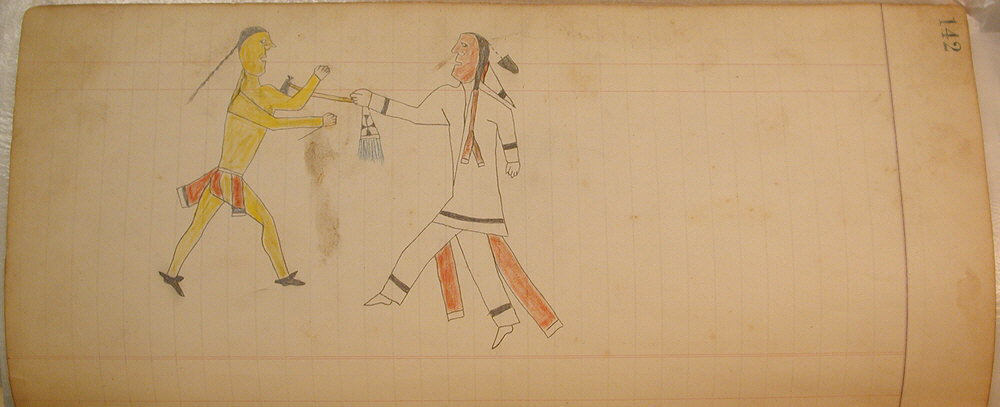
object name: drawing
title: Maffet Ledger: Drawing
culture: cheyenne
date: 1874-1881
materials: crayon, graphite, paper, watercolor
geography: united states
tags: weapons,men